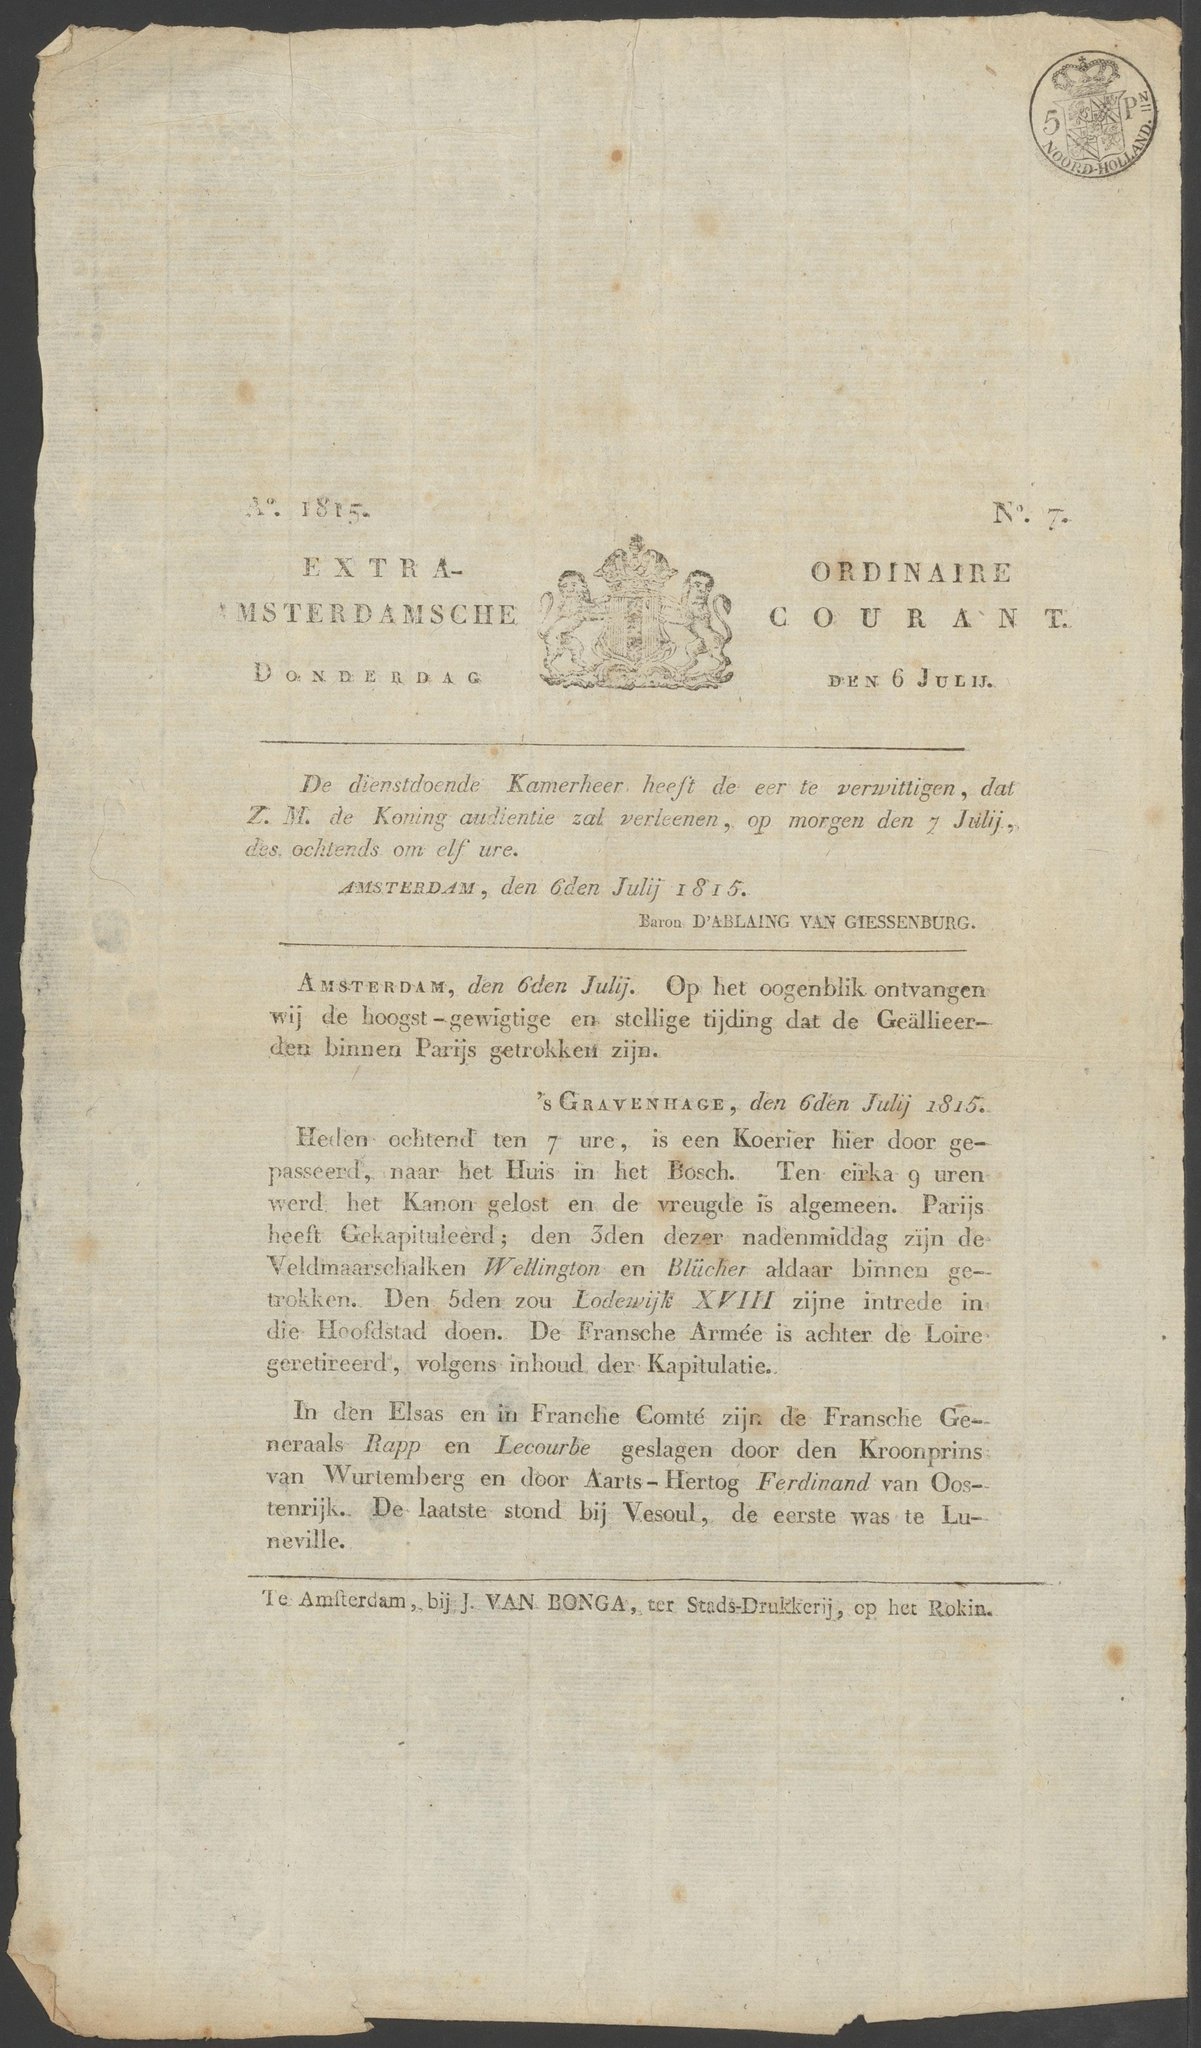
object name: newspaper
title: Extra-Ordinaire Amsterdamsche Courant, 6 juli 1815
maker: jacobus van bonga jr.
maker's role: printer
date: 1815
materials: paper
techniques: letterpress printing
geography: amsterdam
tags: newspaper, news-sheet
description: Exemplaar van de krant 'Extra-Ordinaire Amsterdamsche Courant' van 6 juli 1815. Enkelbladig, één zijde bedrukt. Bovenaan een vignet met het stadswapen. Rechtsboven een stempel betaalde accijnzen. Onderwerpsrubrieken binnen de Atlas Zeden en Gewoonten: Regeering, Officieele Nieuwsbladen.